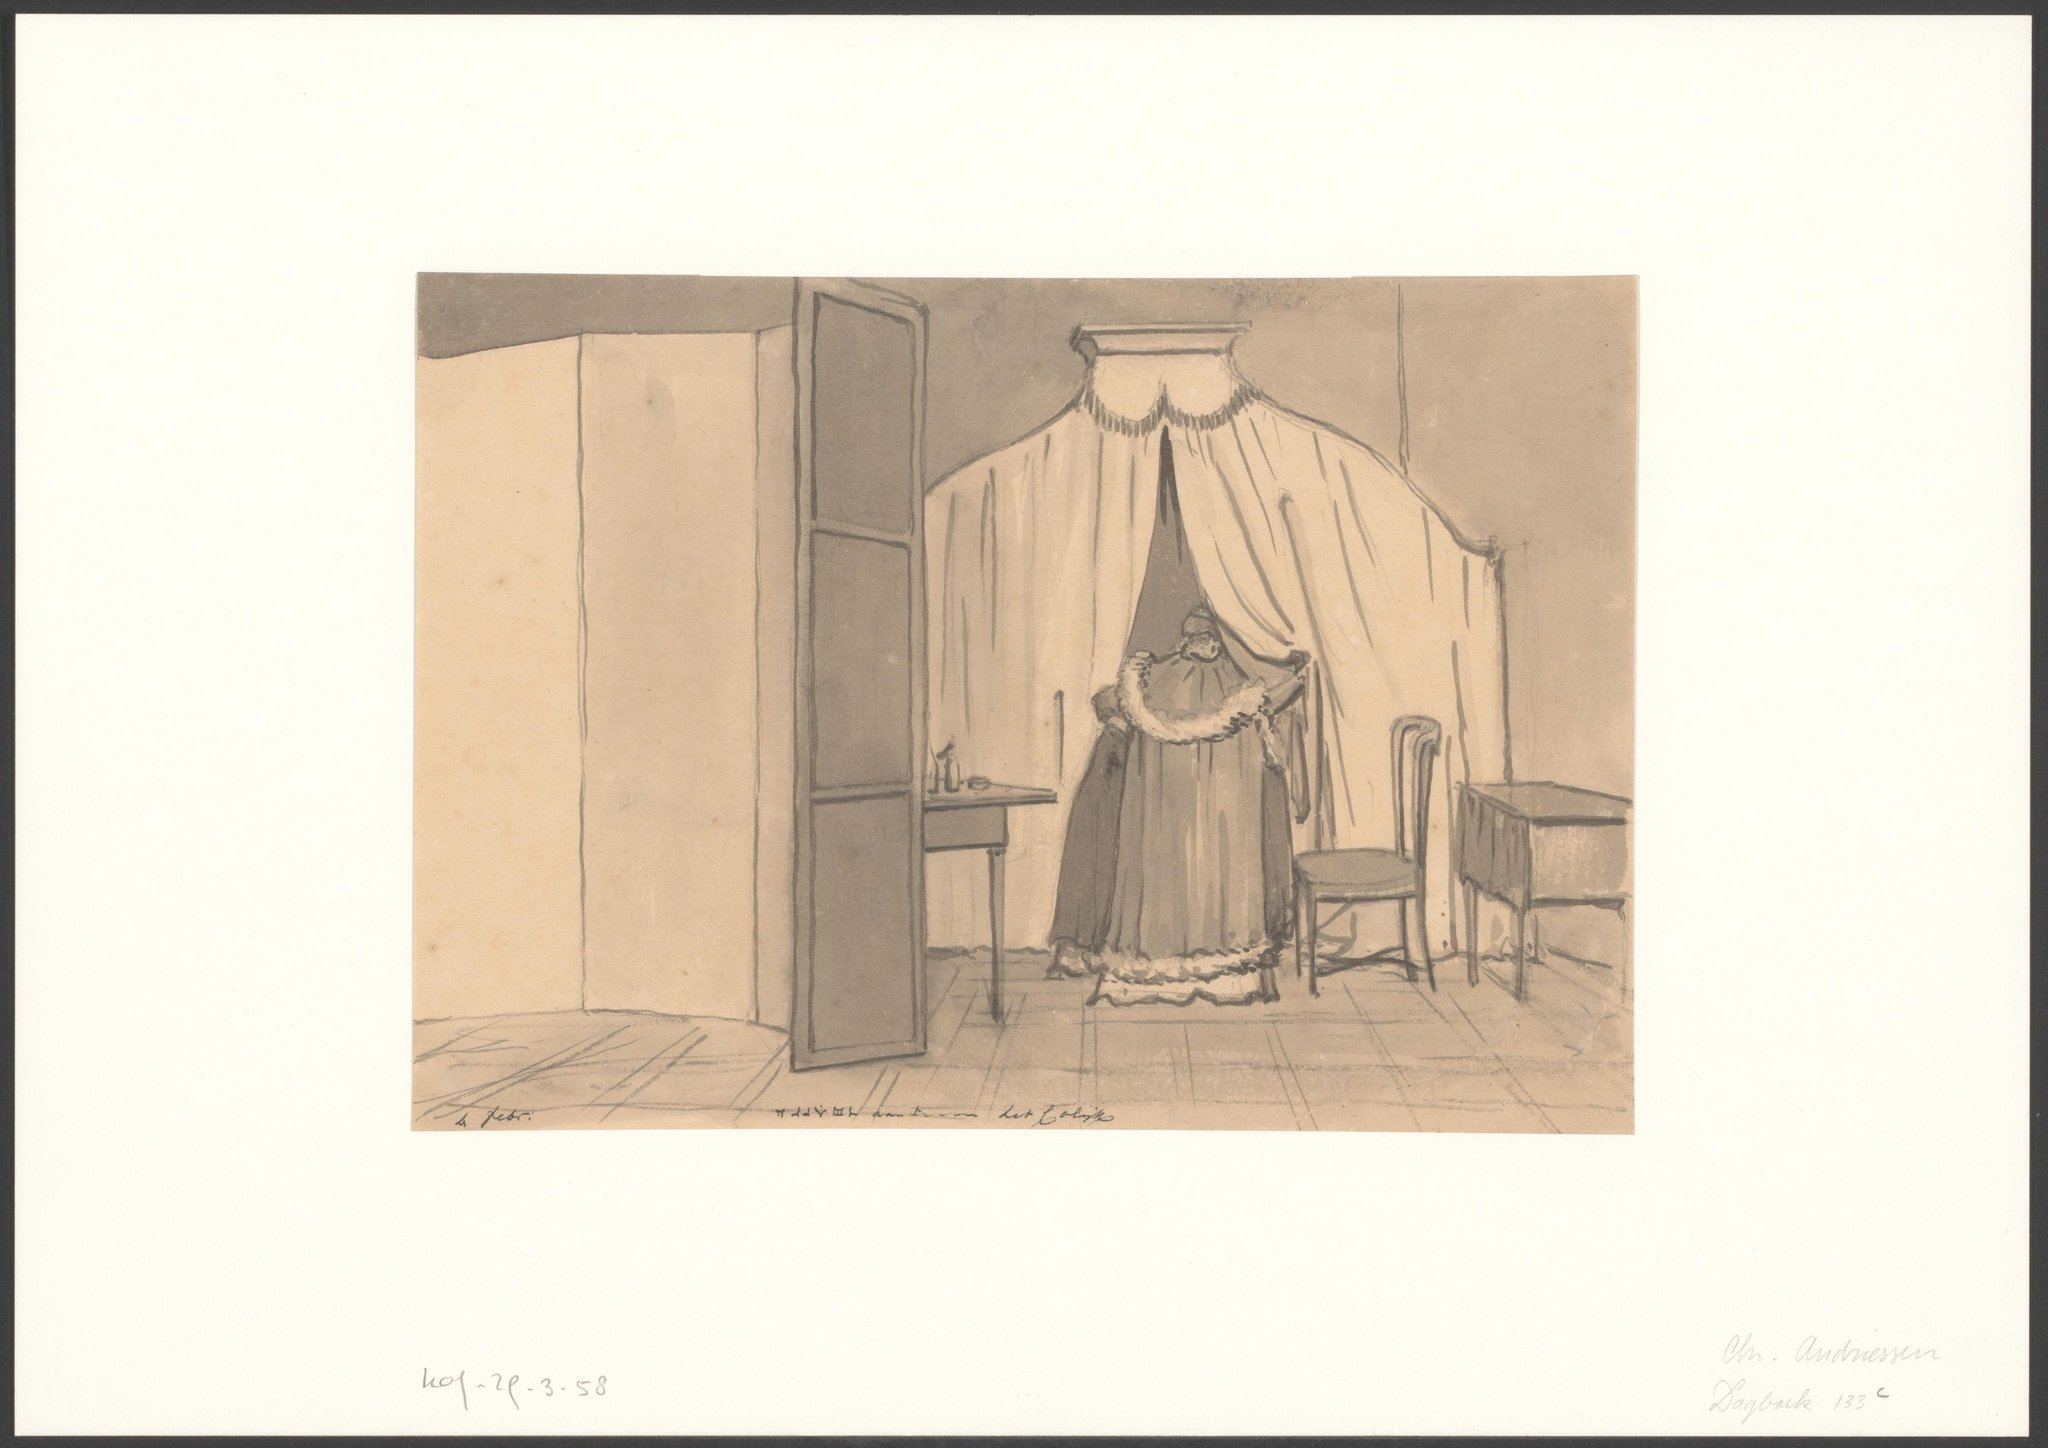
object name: drawing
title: Moeder en kinderen kijken naar een zieke op bed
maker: christiaan andriessen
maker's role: draughtsman, print maker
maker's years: 1775-1846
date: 1805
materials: ink, paper, pencil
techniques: brush, pen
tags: amsterdam, print maker, draughtsman, christiaan andriessen, sick-bed, bed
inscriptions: inscription: ‘J Andriessen’, inscription: ‘4 febr de zieke Het Colijk’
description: Dagboekblad uit het getekende dagboek dat Christiaan Andriessen bijhield van 1805 tot en met 1808.